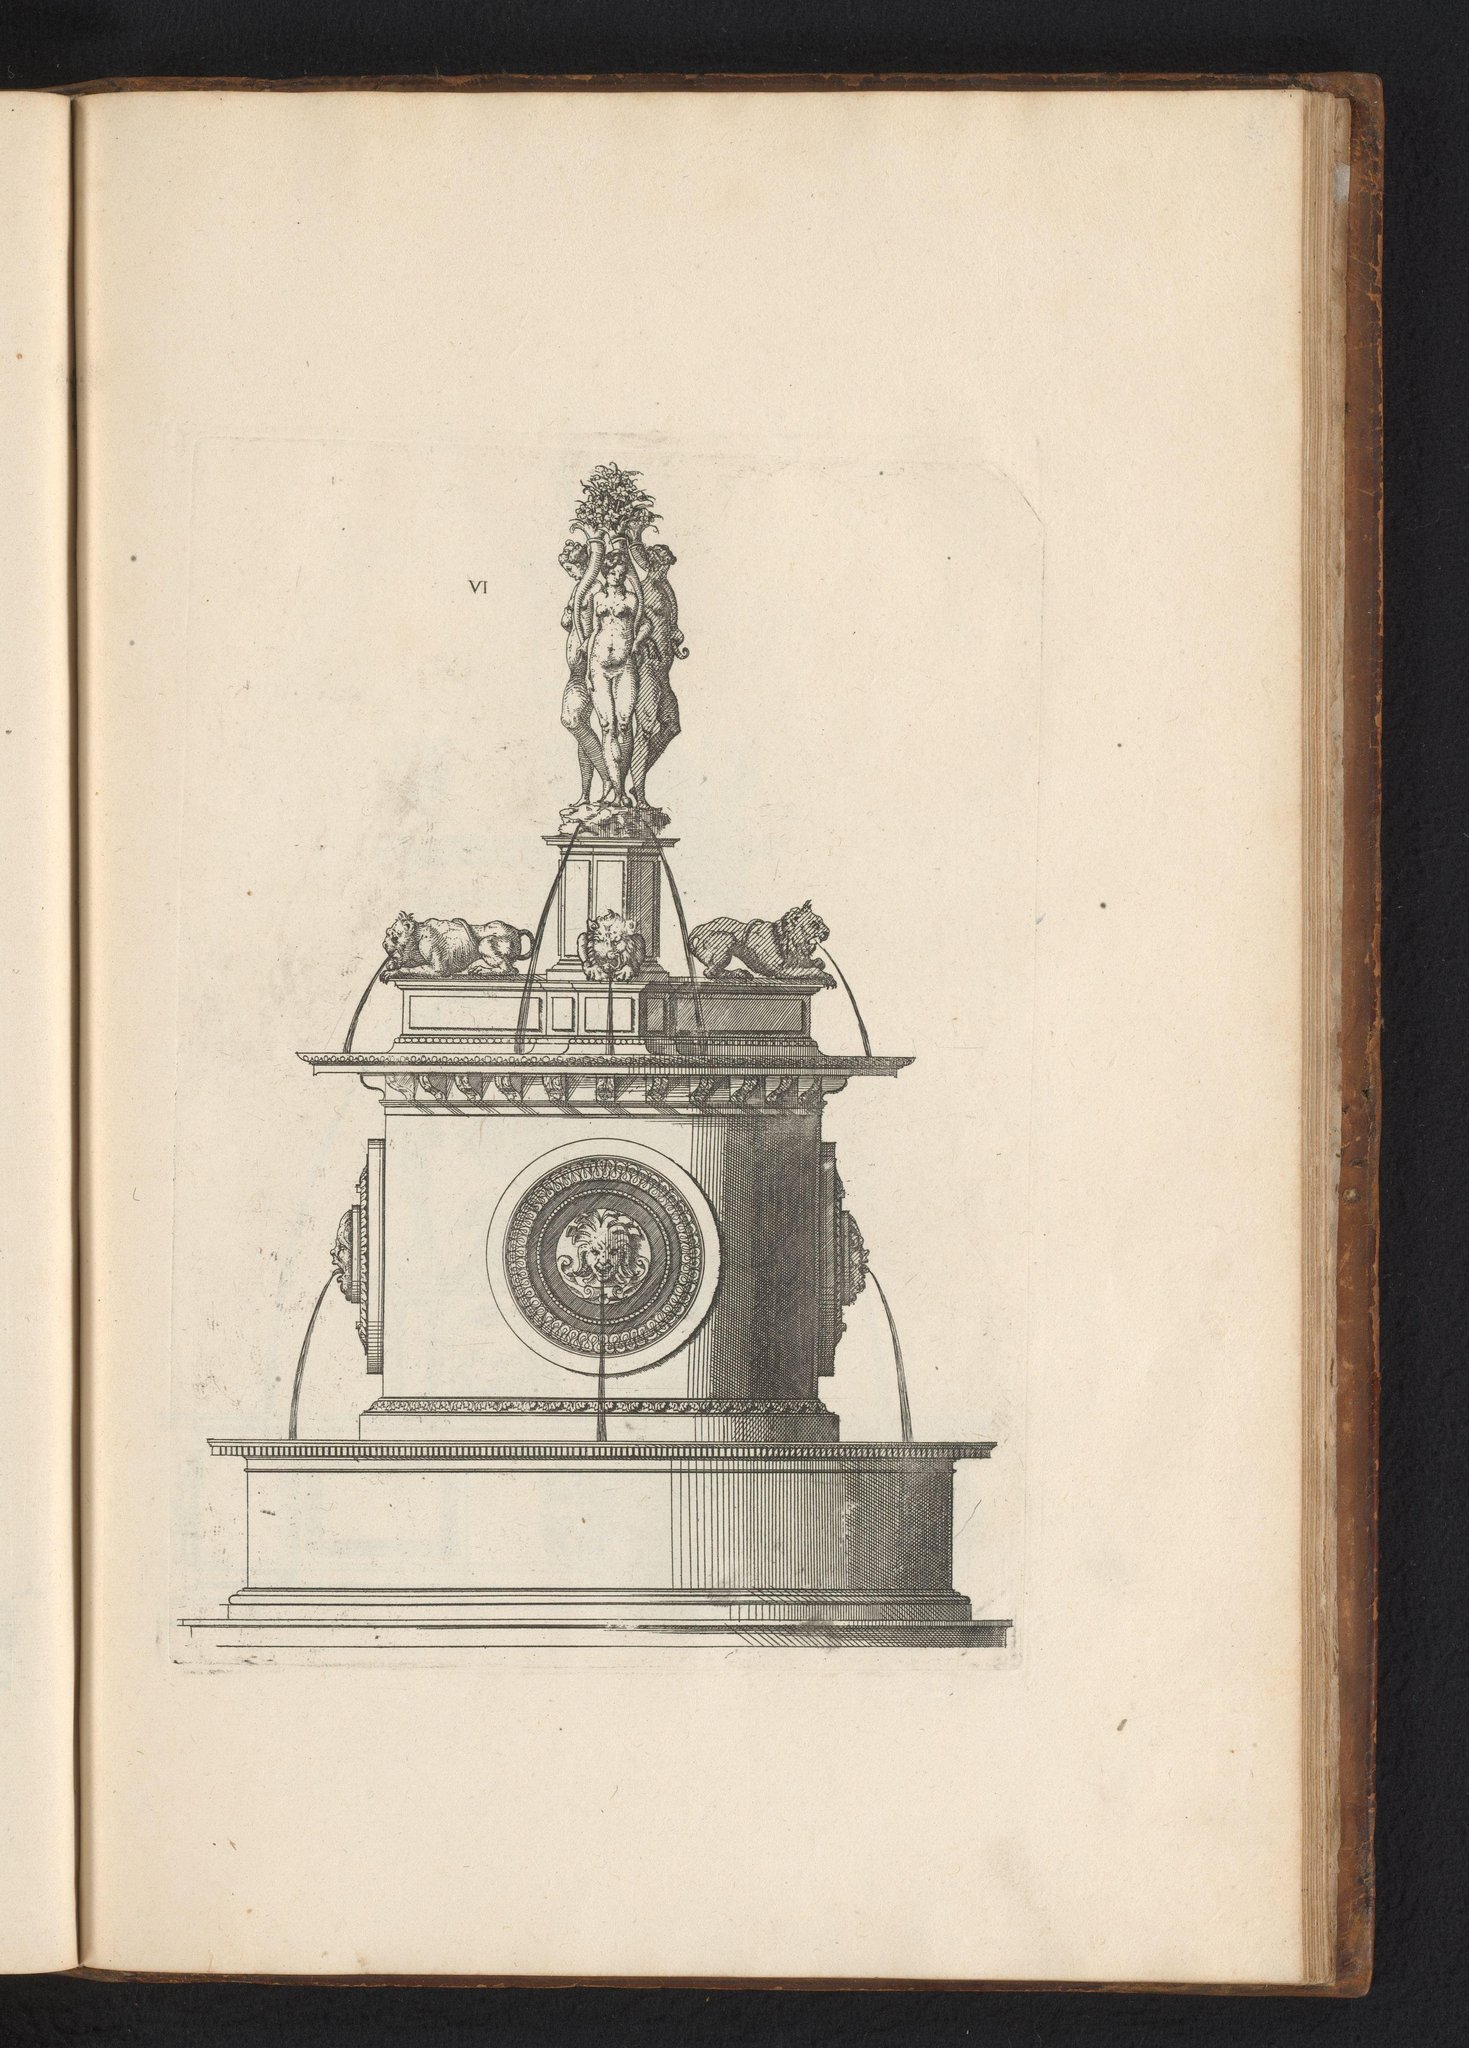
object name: ornament print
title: Fontein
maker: jacques androuet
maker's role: draughtsman, print maker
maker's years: 1515-1584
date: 1561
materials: paper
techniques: etching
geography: paris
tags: garden fountain, ornamental fountain, architectural design or model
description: Fontein met drie vrouwenfiguren en leeuwen. Onderdeel van 'Seconde livre d'architectvre' (1561): 64 etsen met geornamenteerde architectuuronderdelen.